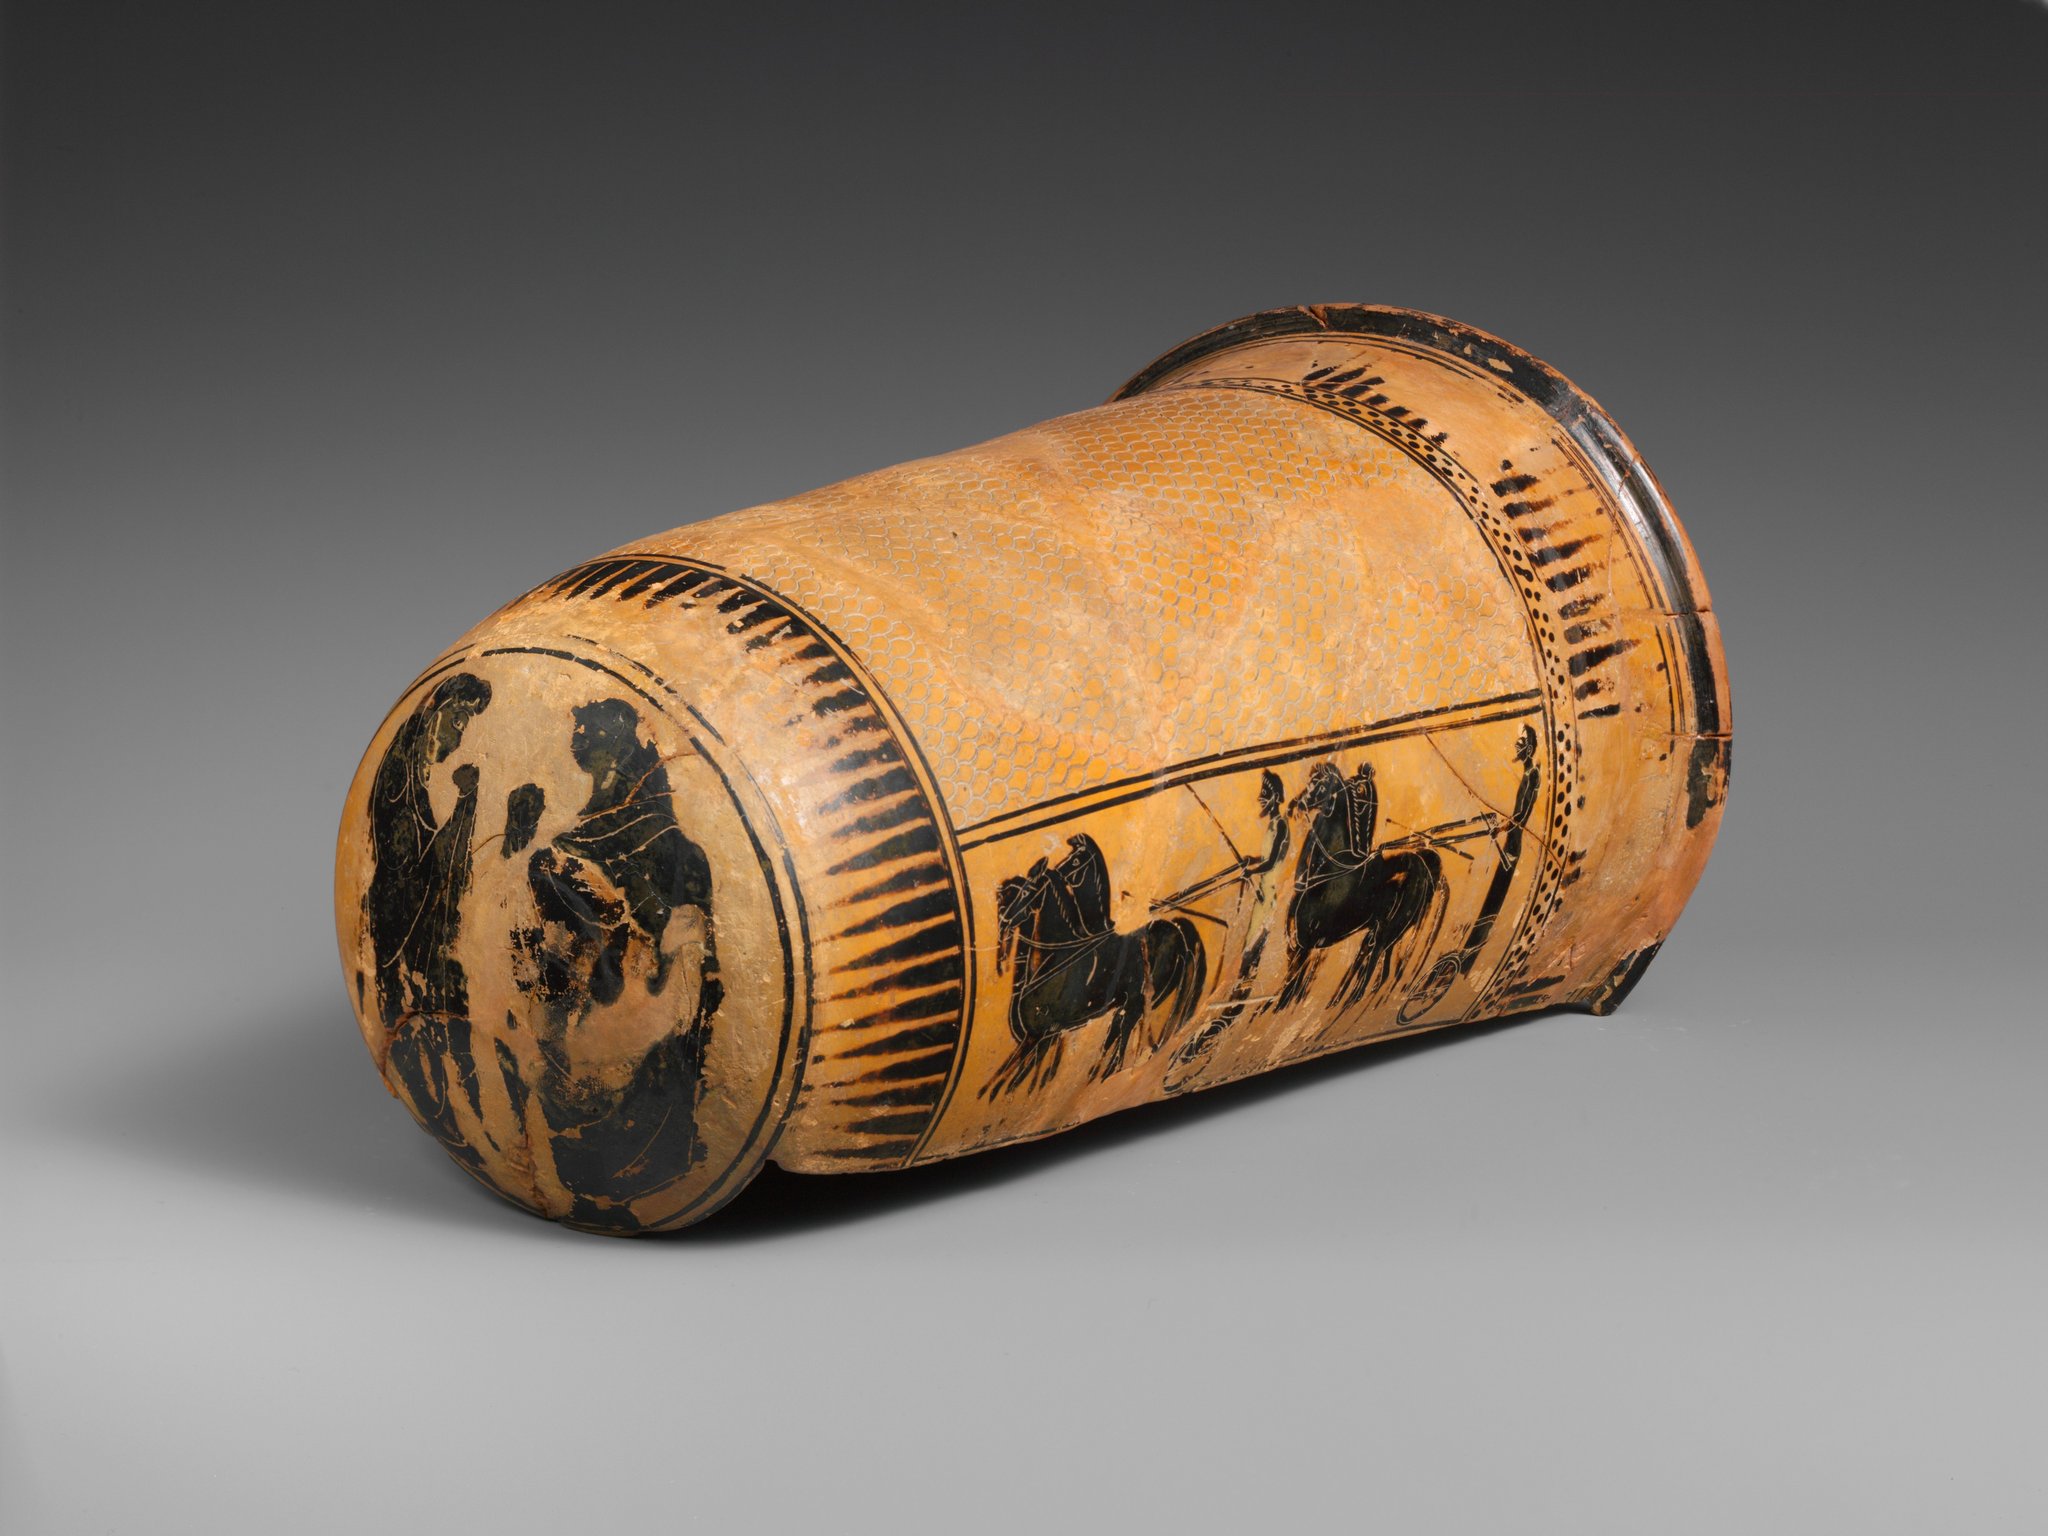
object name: ono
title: Terracotta onos (leg guard used in carding wool)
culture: greek, attic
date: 525-501 BCE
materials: terracotta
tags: men,horses,chariots